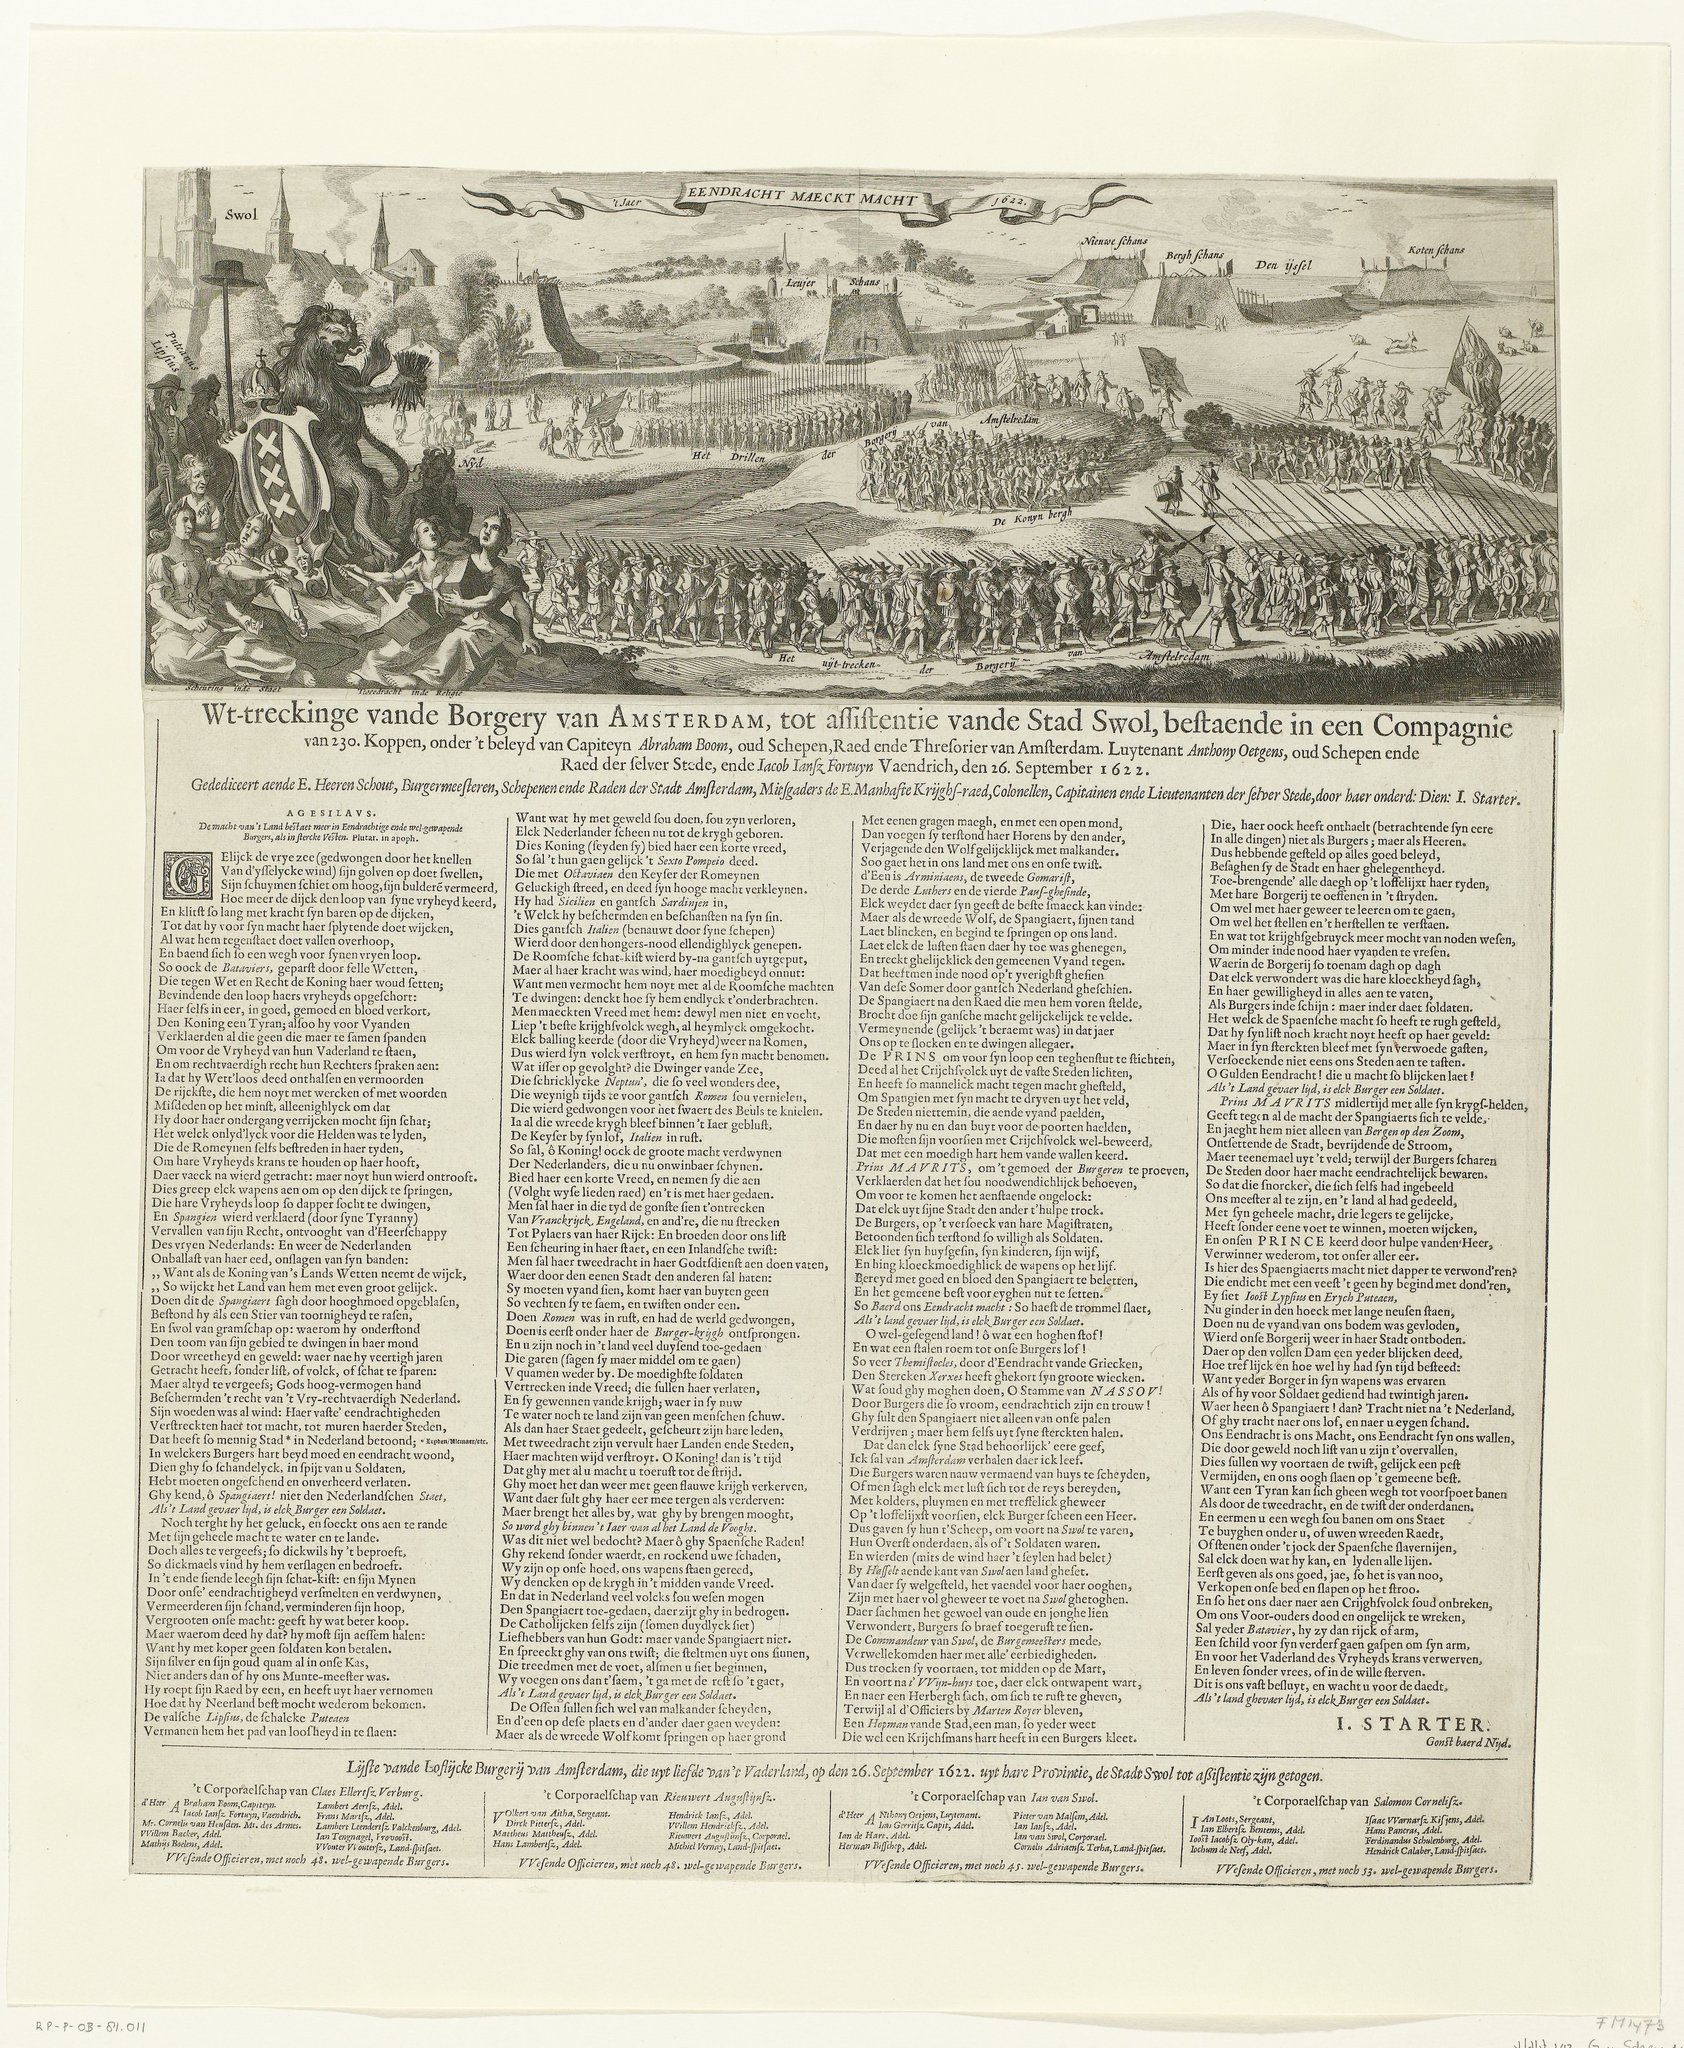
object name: print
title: Wt-treckinge vande Borgery van Amsterdam, tot assistentie vande Stad Swol, bestaende in een Compagnie van 230. Koppen (...) 26 September 1622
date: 1622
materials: paper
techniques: etching, letterpress printing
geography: northern netherlands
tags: erycius puteanus, louvain, justus lipsius, troop movements, transportation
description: Tocht van de schutterij van Amsterdam naar Zwolle ter assistentie van de verdediging tijdens de Spaanse aanval op de stad, 26 september 1622. Links de stad, centraal de oprukkende schutters. Links de Hollandse Leeuw met het wapen van Amsterdam. Hierbij ook de allegorische figuren van Twist, Nijd, Scheuring in de Staet en Tweedracht in de Religie. Achteraan staan met lange neuzen Justus Lipsius en Erycius Puteanus. Vastgeplakt onder de voorstelling een tekstblad met een lang vers in 4 kolommen en onderaan een lijst van de verschillende korporaalschappen van de Amsterdamse schutters met namenlijsten van hun officieren.